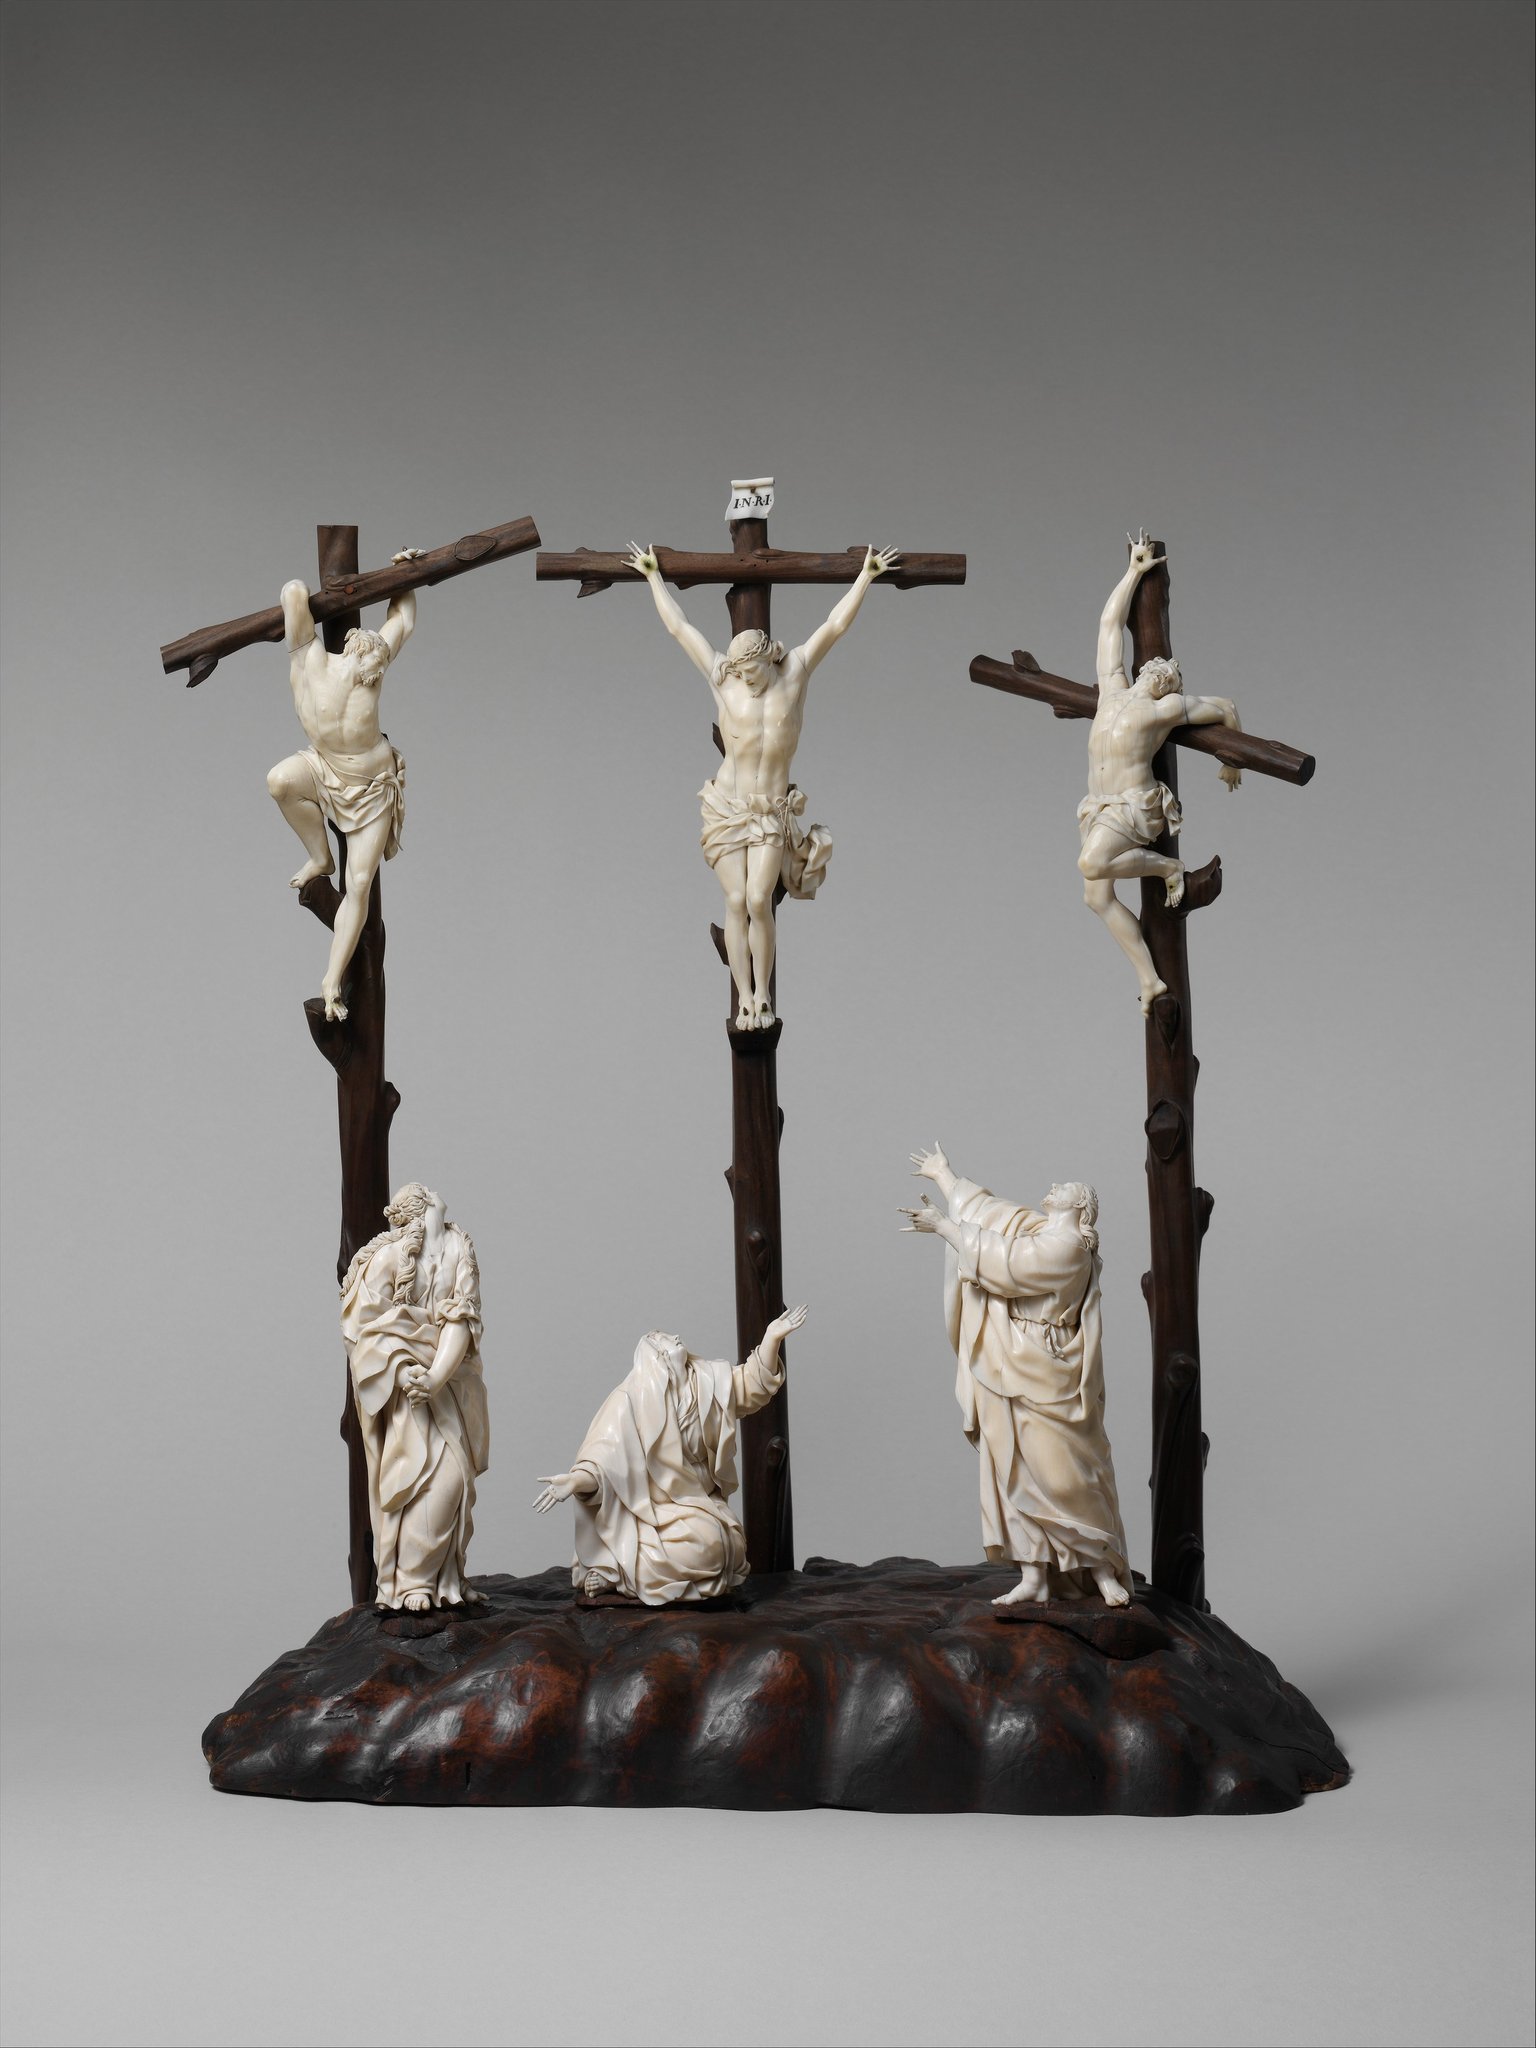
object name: group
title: Crucifixion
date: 1667-1733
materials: wood, ivory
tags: christ,mary magdalene,saint john the evangelist,virgin mary,crucifixion